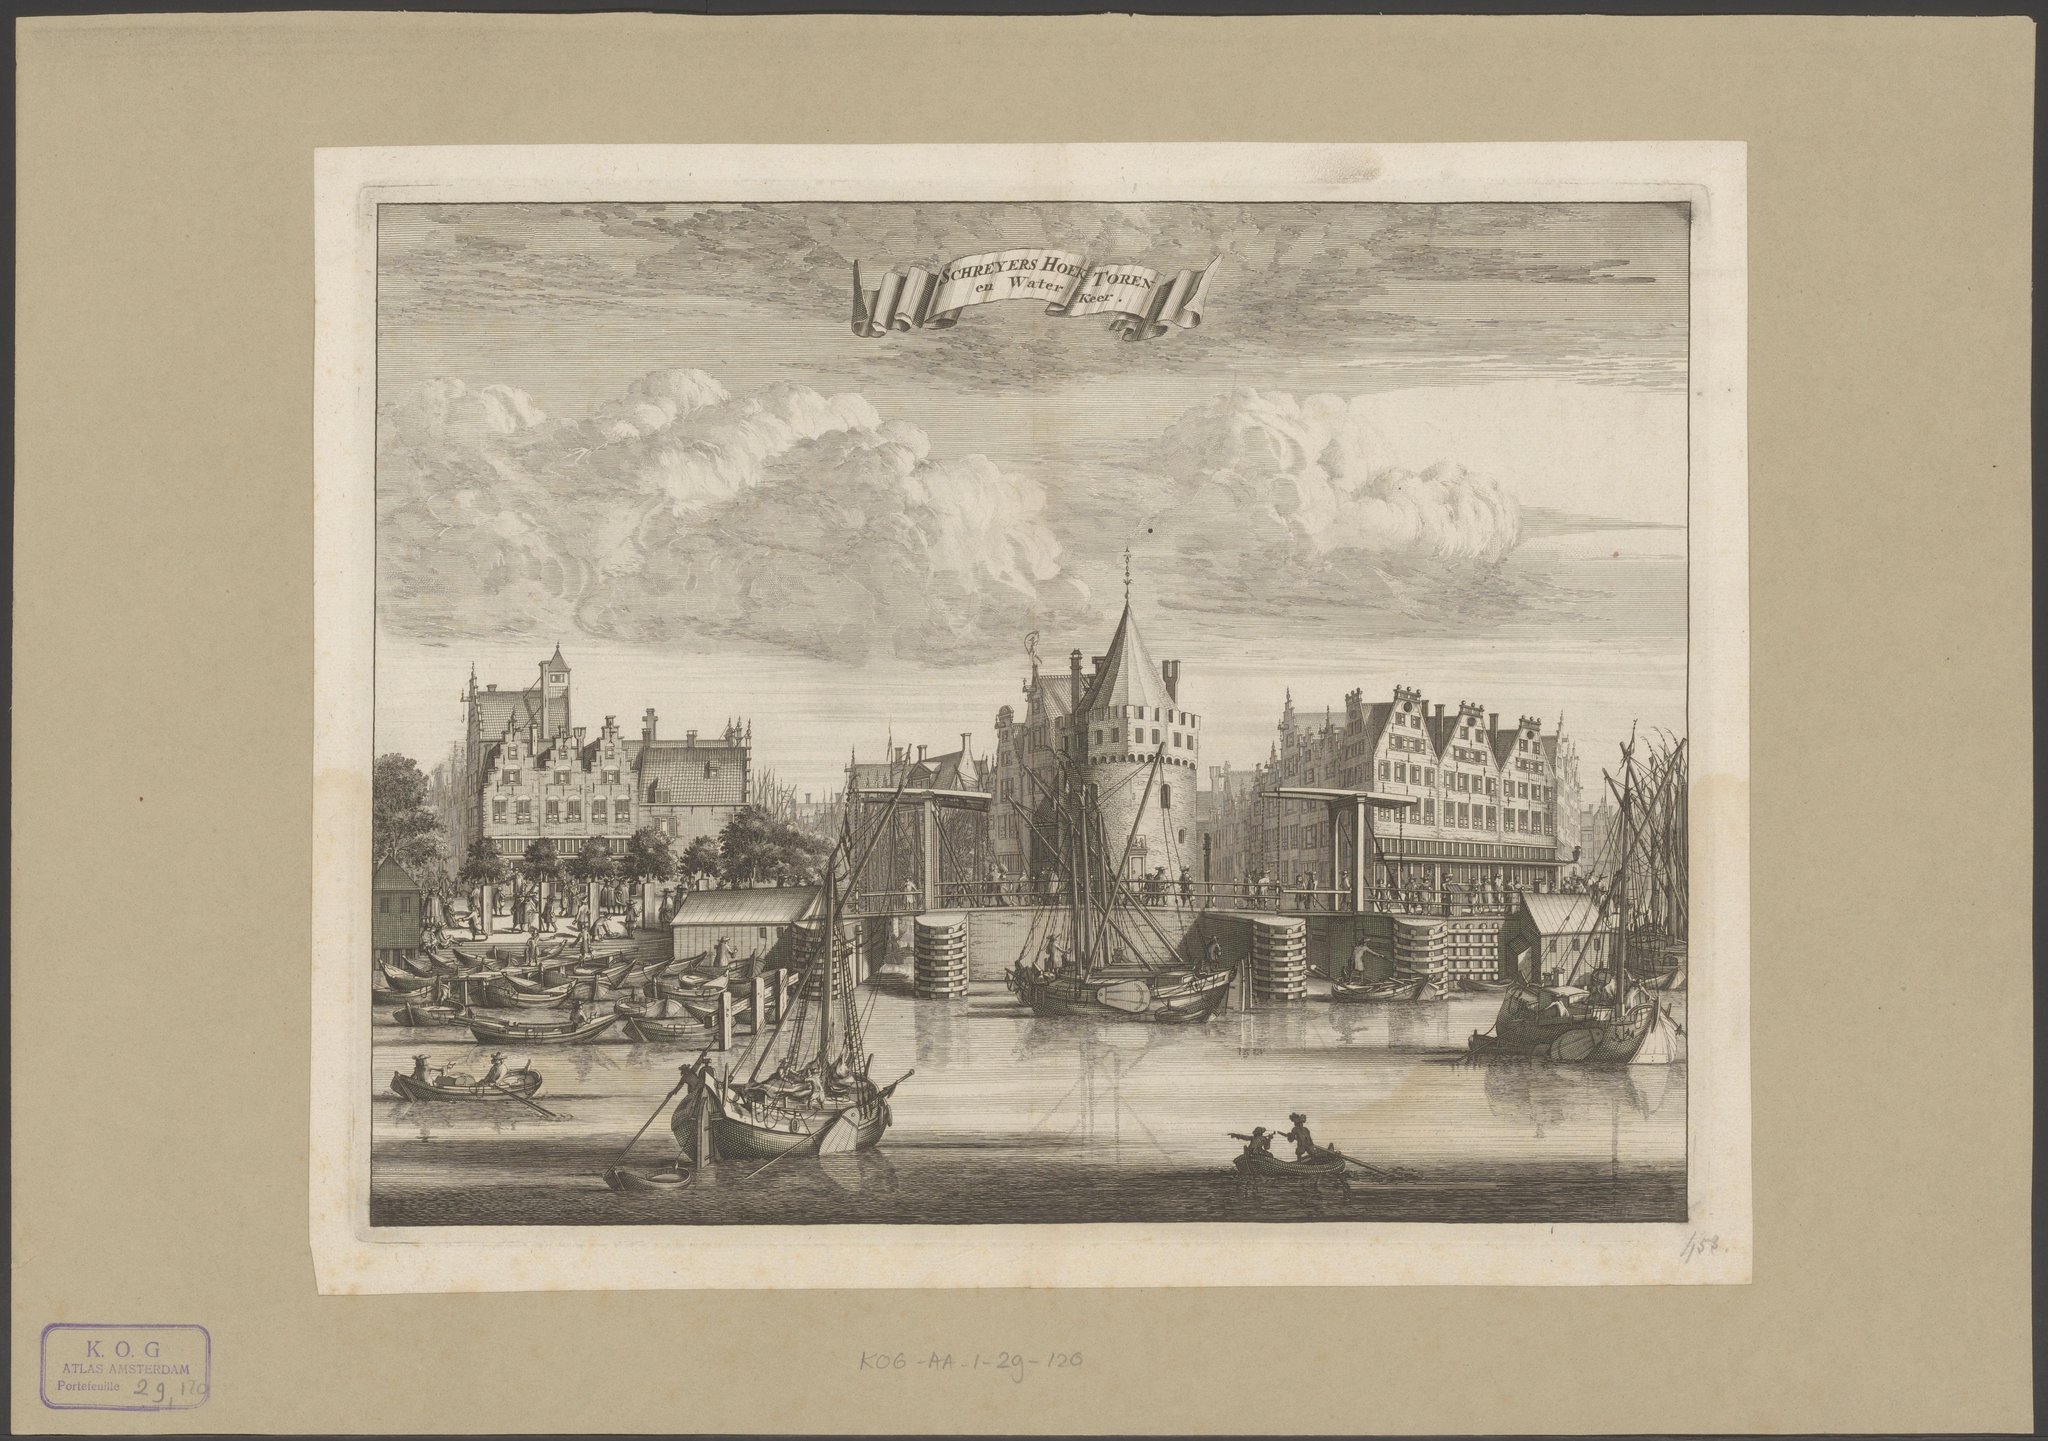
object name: print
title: Schreyers Hoek Toren en Water Keer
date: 1726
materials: paper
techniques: engraving, etching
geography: amsterdam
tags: sluice, weir, bridge in city across river, canal, etc. (+ city(-scape) with figures, staffage), sailing-ship, sailing-boat, towers ~ fortified city, rowing-boat, canoe, etc.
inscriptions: collector's mark: Lugt 1641b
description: Prent mogelijk uit: Commelin, Casparus. Beschryvinge van Amsterdam (…). 2de druk. Amsterdam: Andries van Damme, Johannes Ratelband, weduwe Antony van Aeltwijk en Hermanus Uytwerf, 1726, dl. 2.